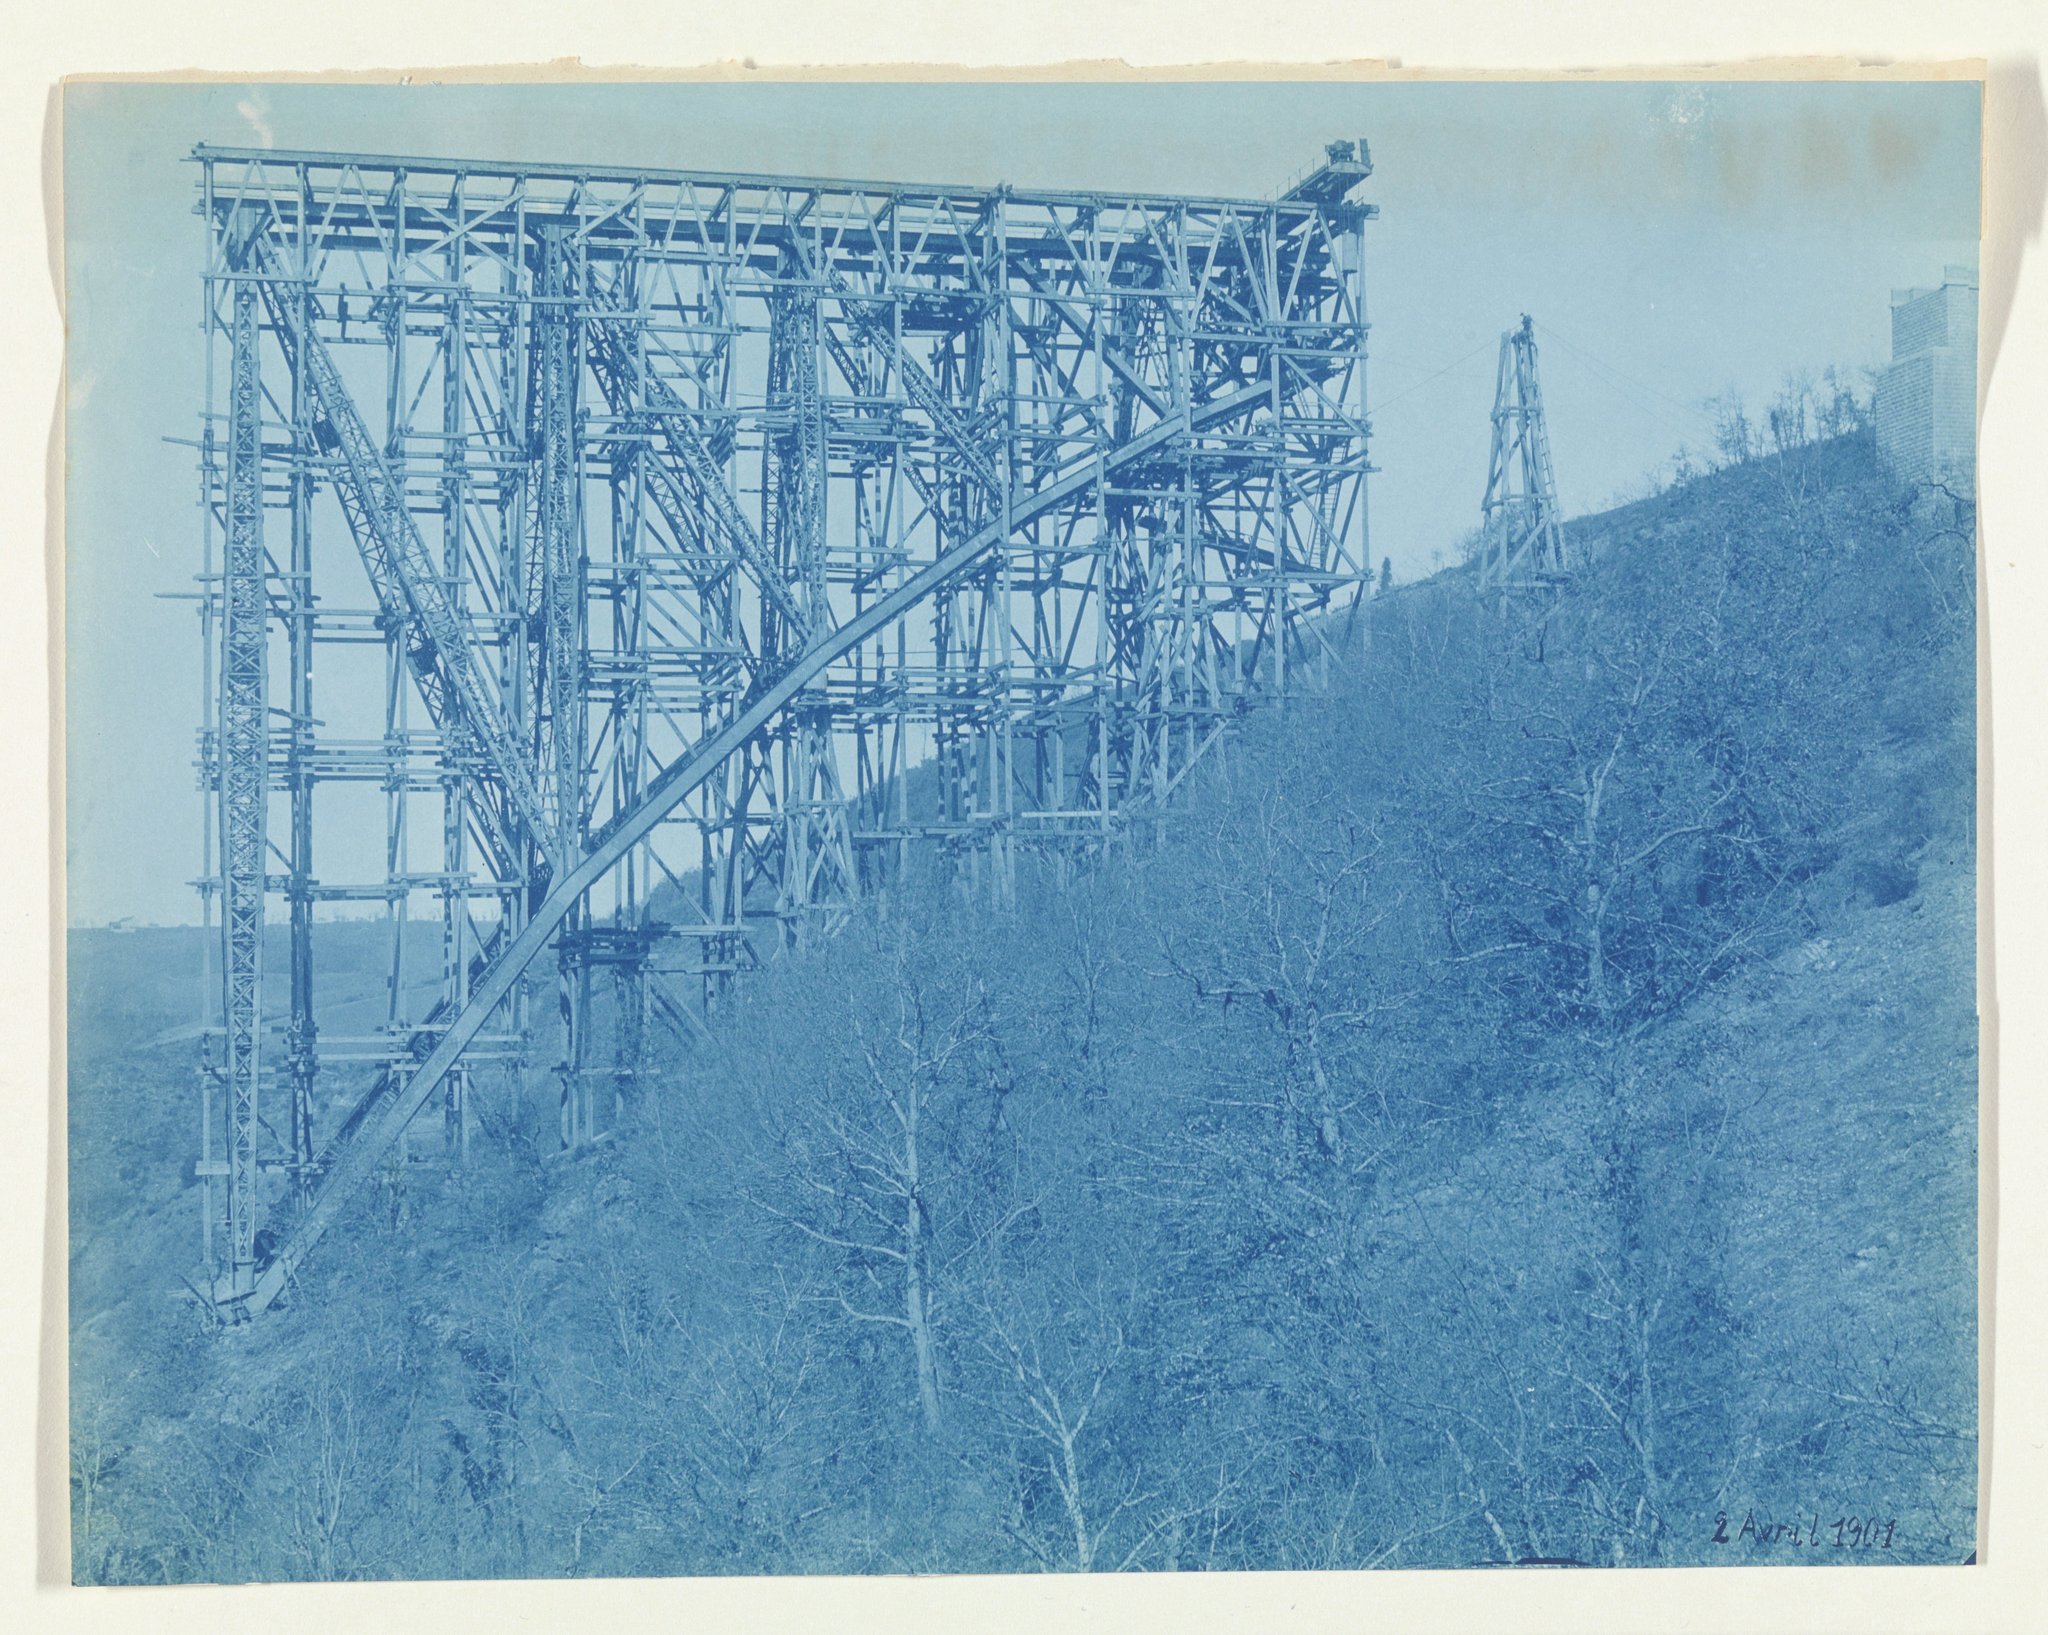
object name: photograph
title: Aanleg van het Viaur Viaduct in Frankrijk door de Societé de Construction des Battignolles, 2 april 1901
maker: Anonymous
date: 1901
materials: photographic support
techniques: cyanotype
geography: france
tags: viaduct, making the overground structures (~ building activities)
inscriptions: date